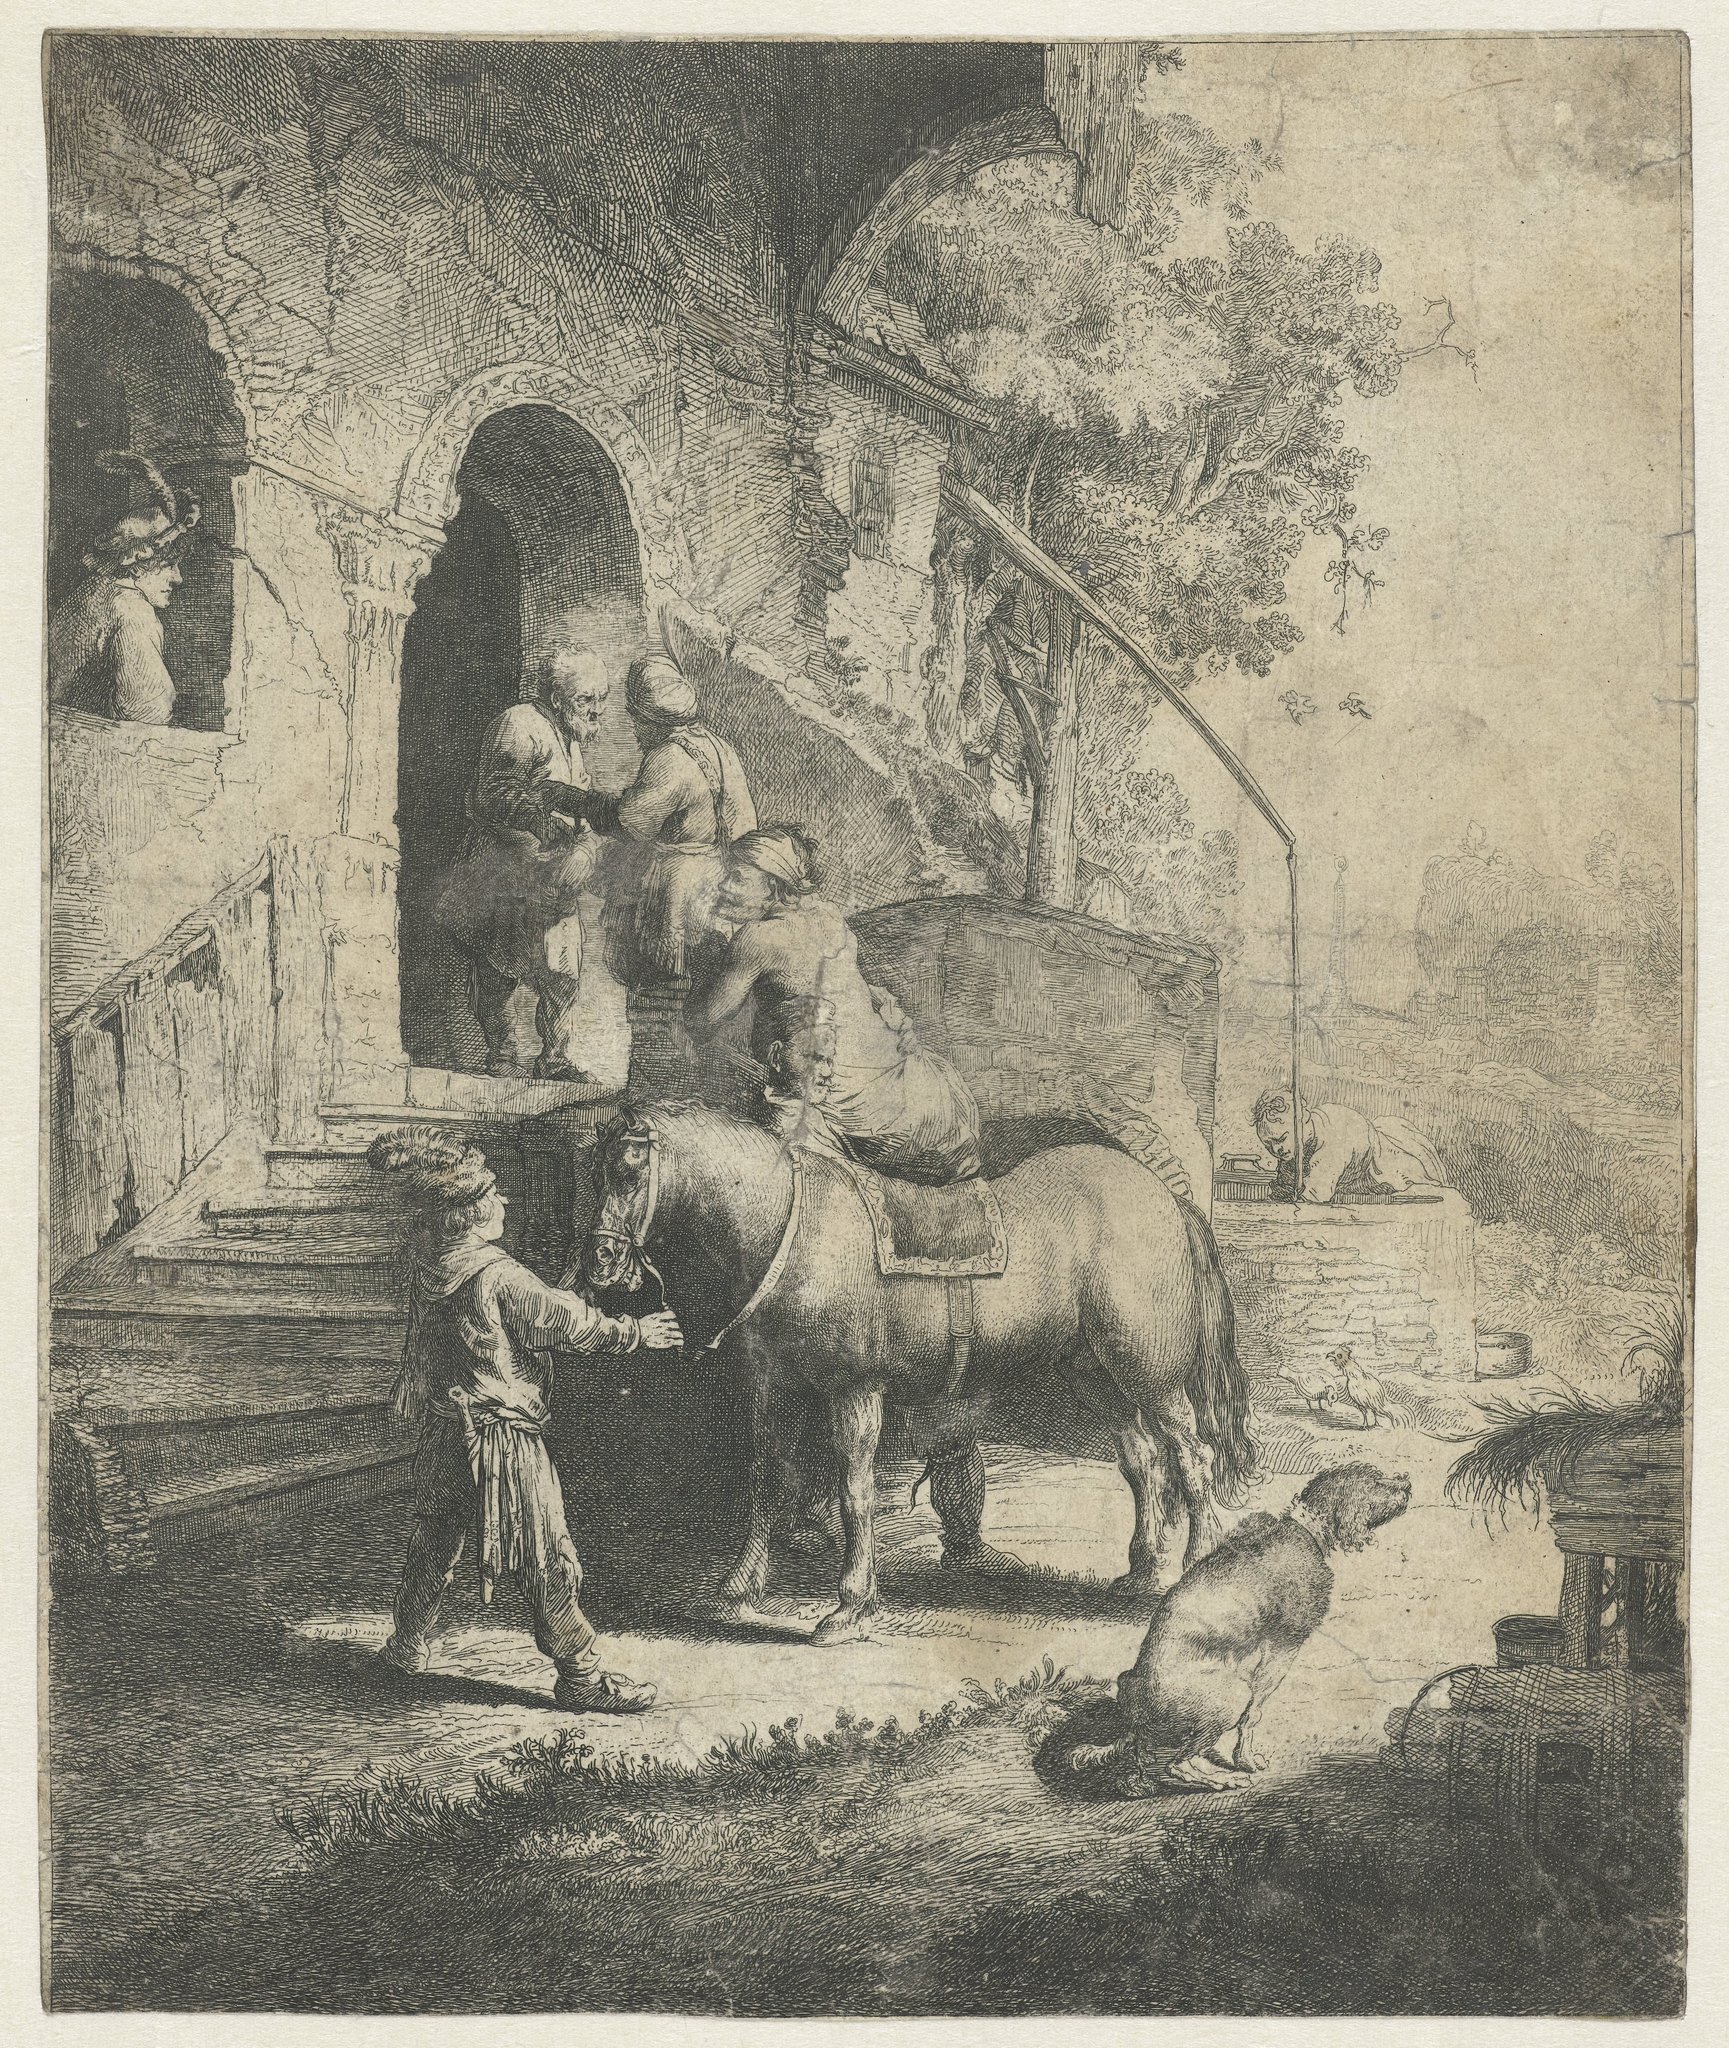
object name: print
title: The Good Samaritan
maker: salomon savery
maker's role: print maker, publisher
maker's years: 1594-1683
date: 1633-1683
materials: paper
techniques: engraving, etching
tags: the good samaritan (luke 10:30-37)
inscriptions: collector's mark: Lugt 2228, collector's mark: Lugt 2760